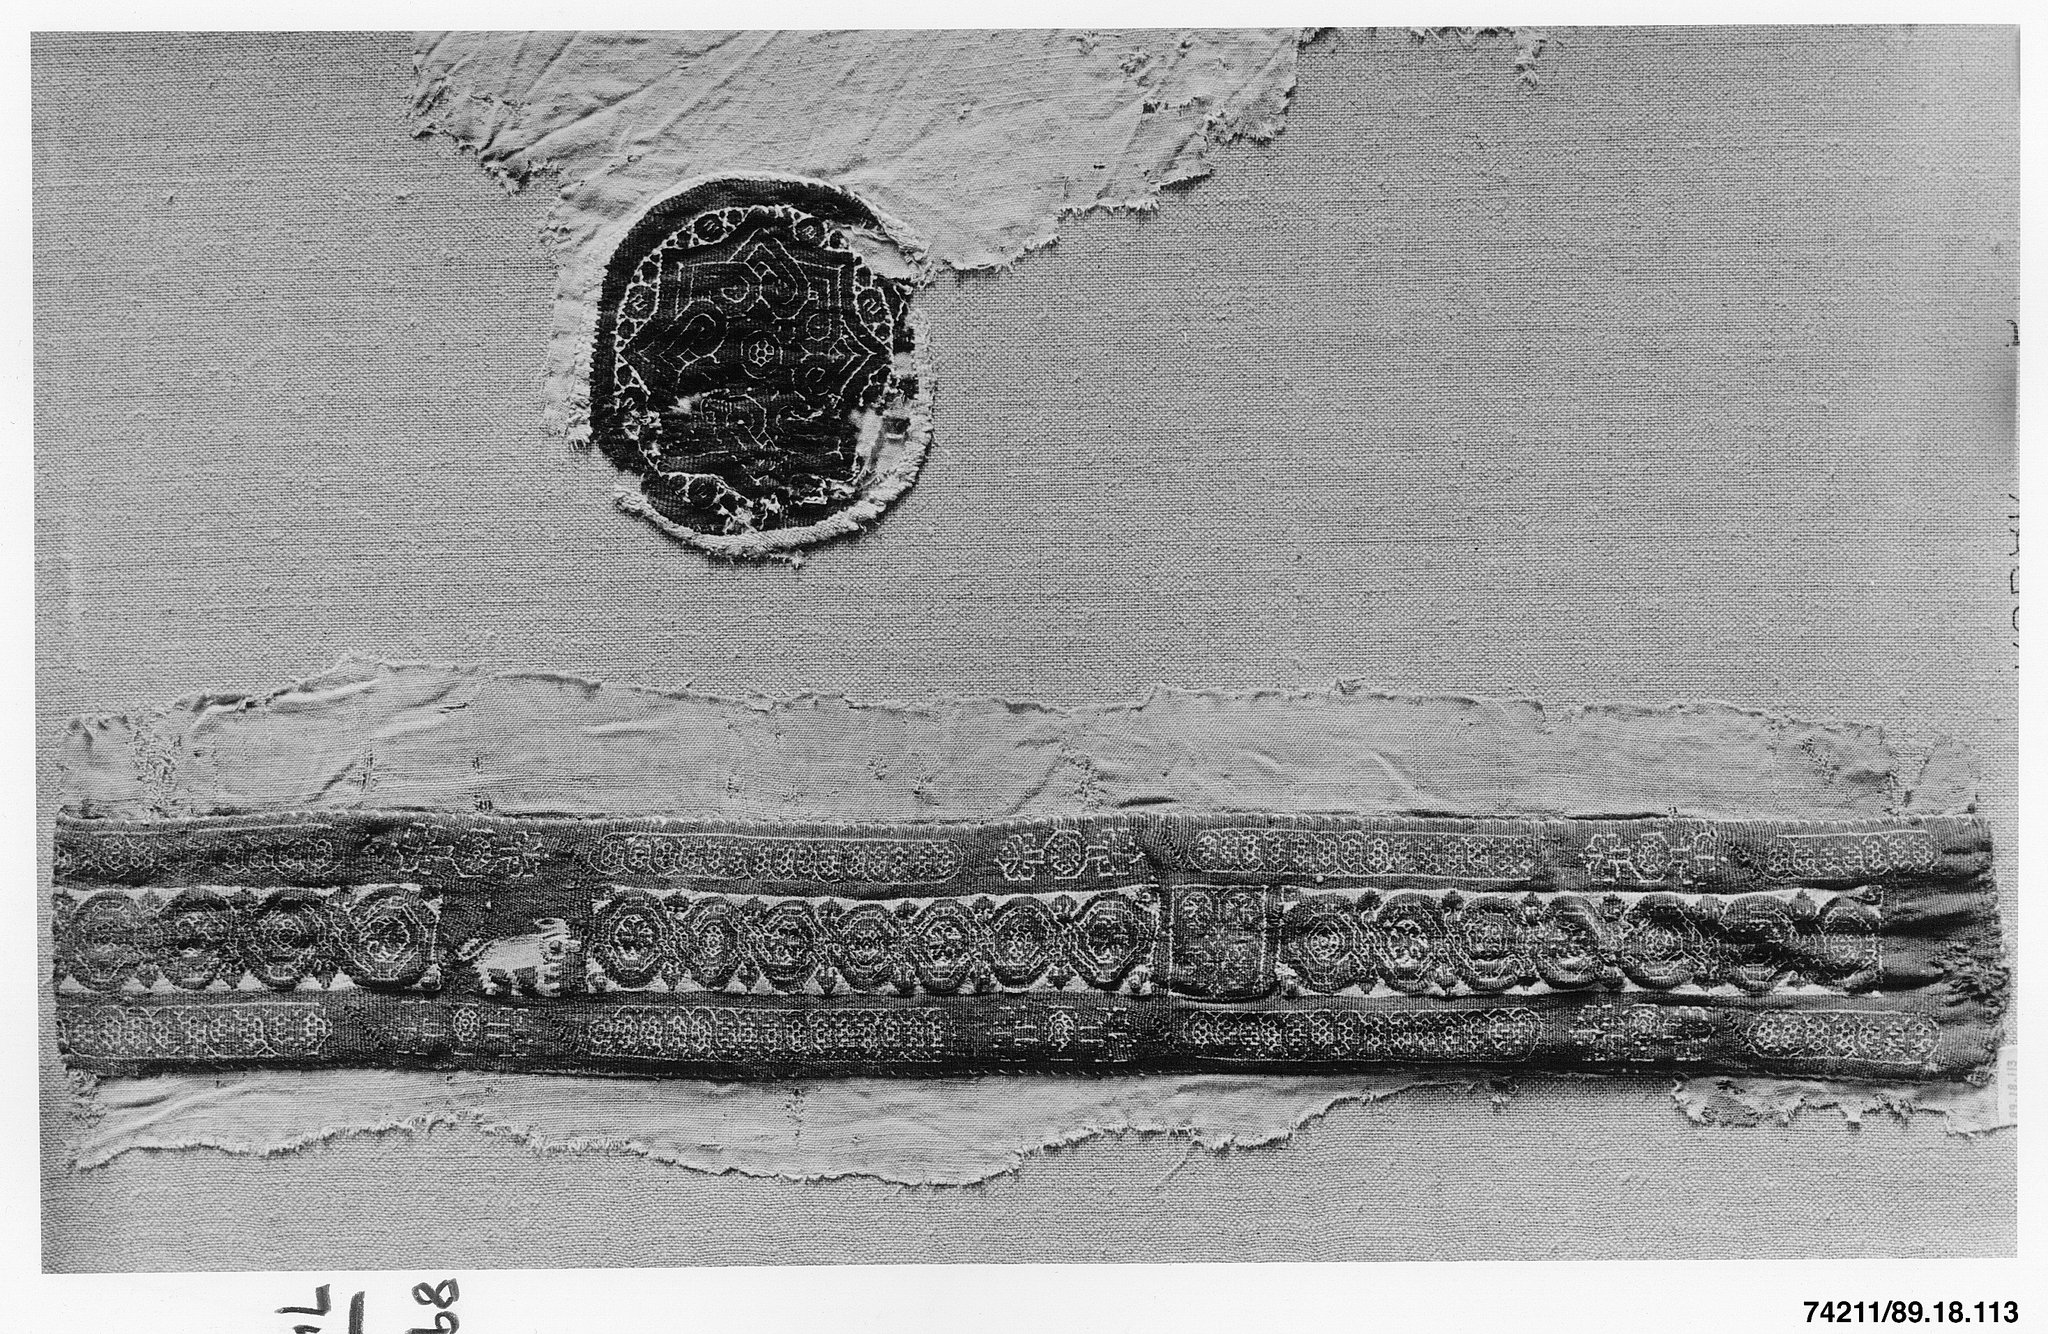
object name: textile fragment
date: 201-400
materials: linen, wool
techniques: weave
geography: egypt